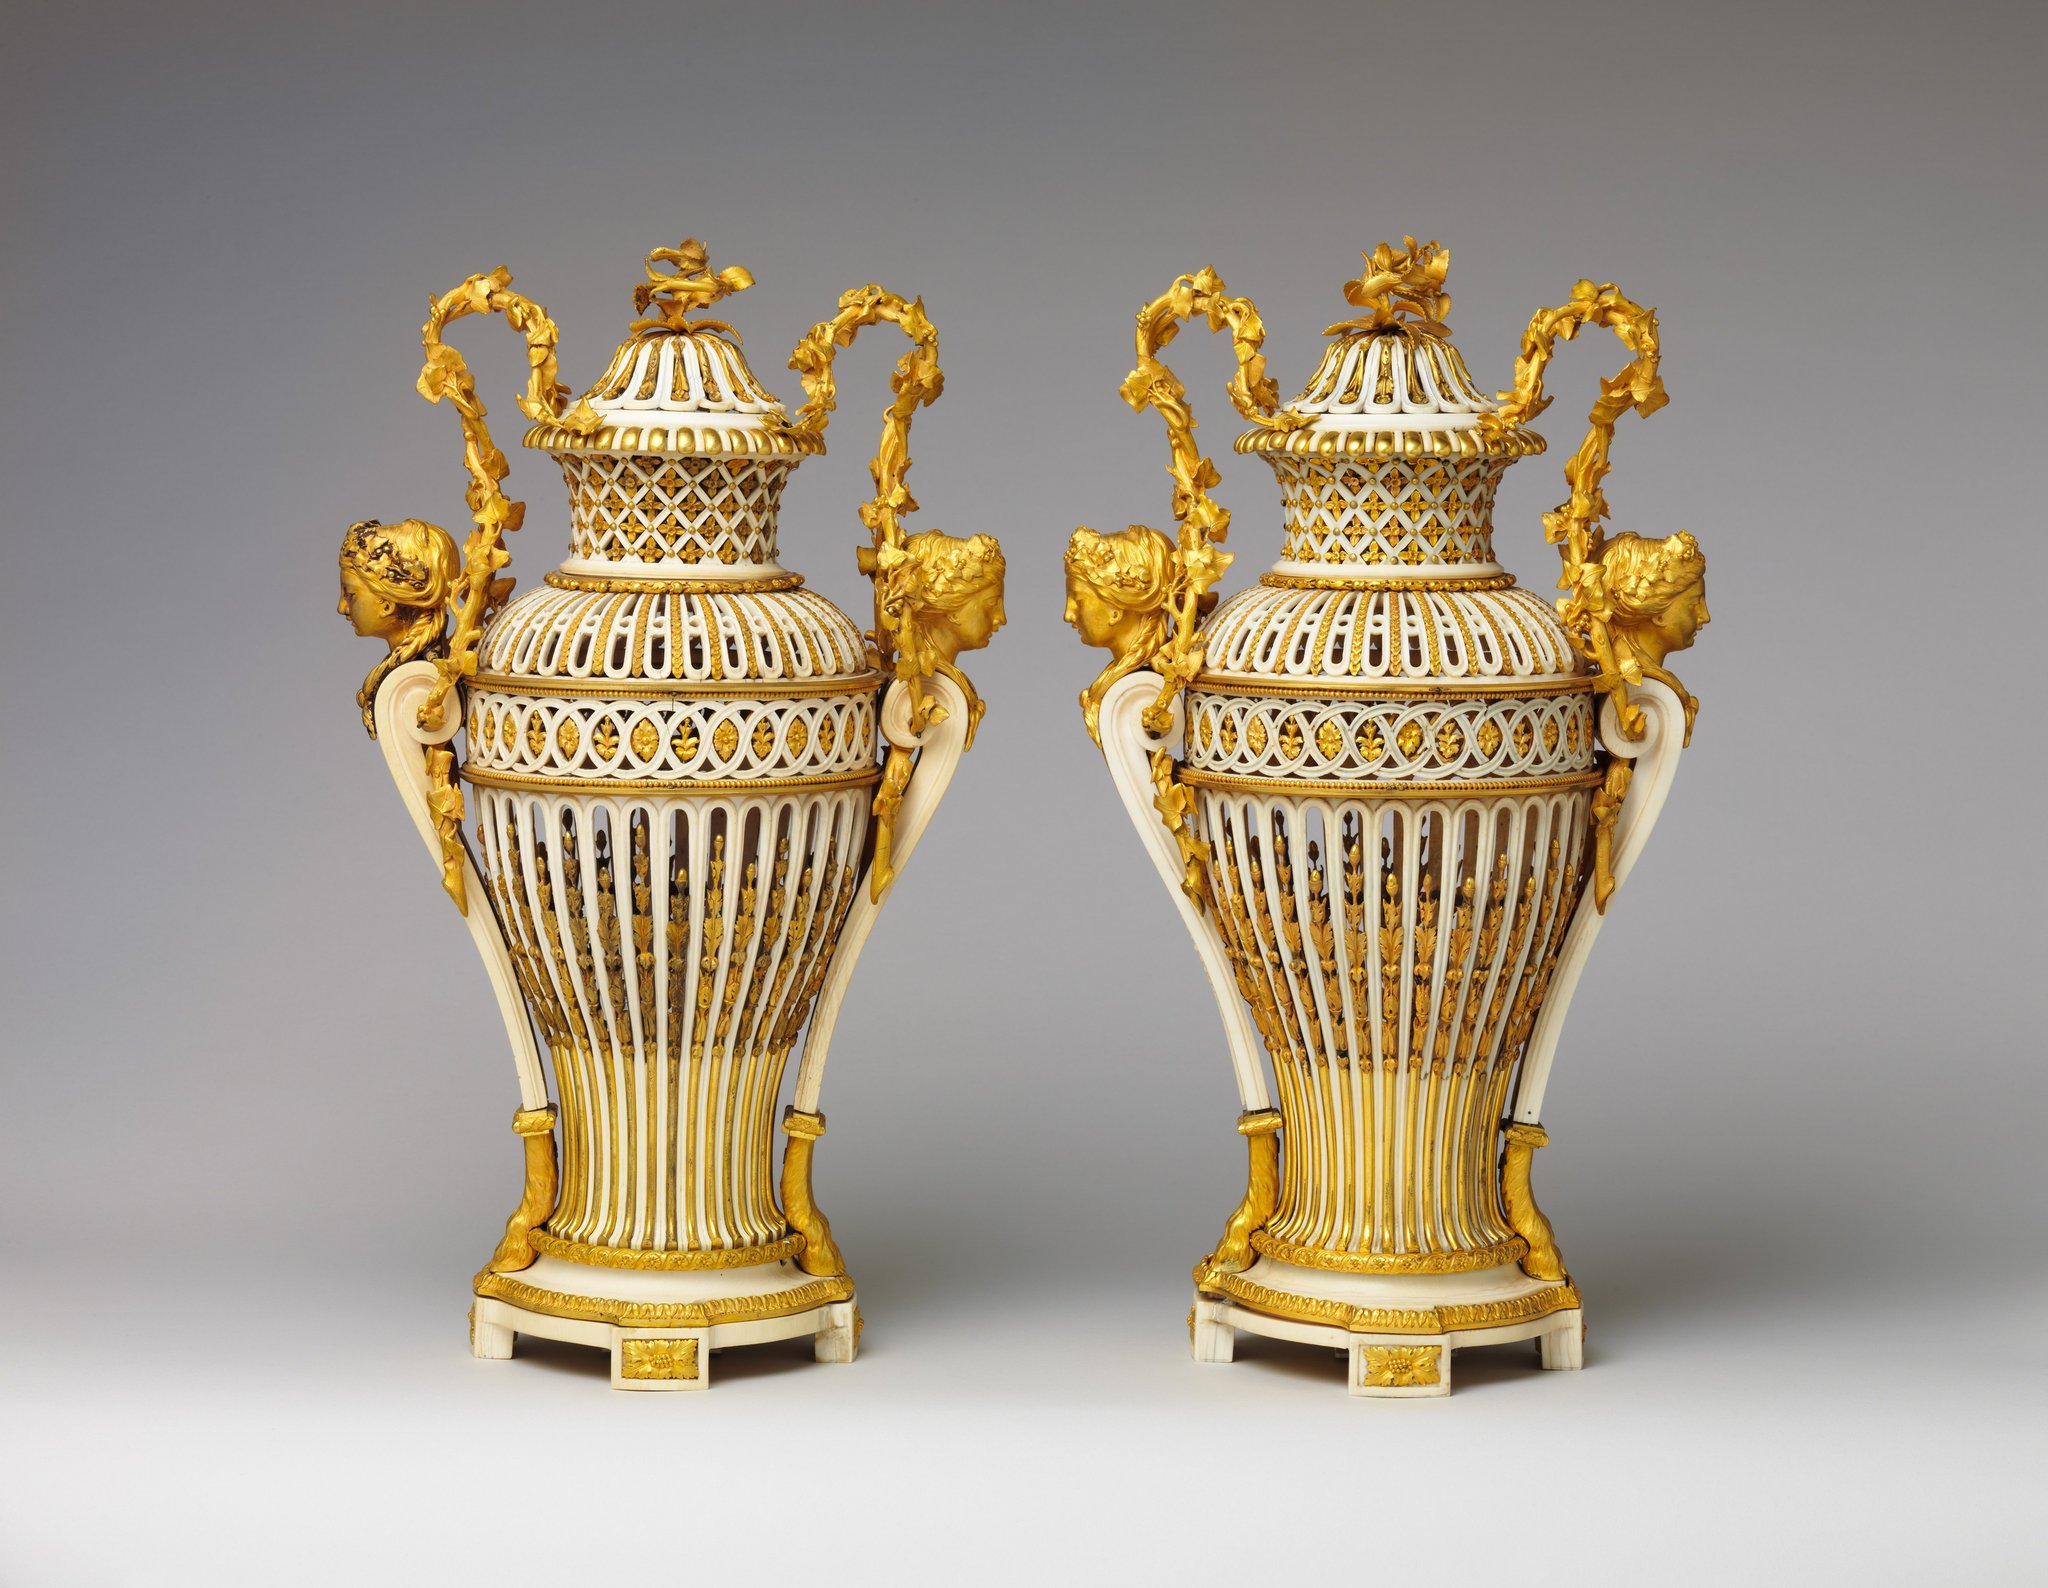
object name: vase with cover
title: Vase with cover (Vase en ivoire) (one of a pair)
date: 1786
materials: gilt bronze, ivory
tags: caryatids